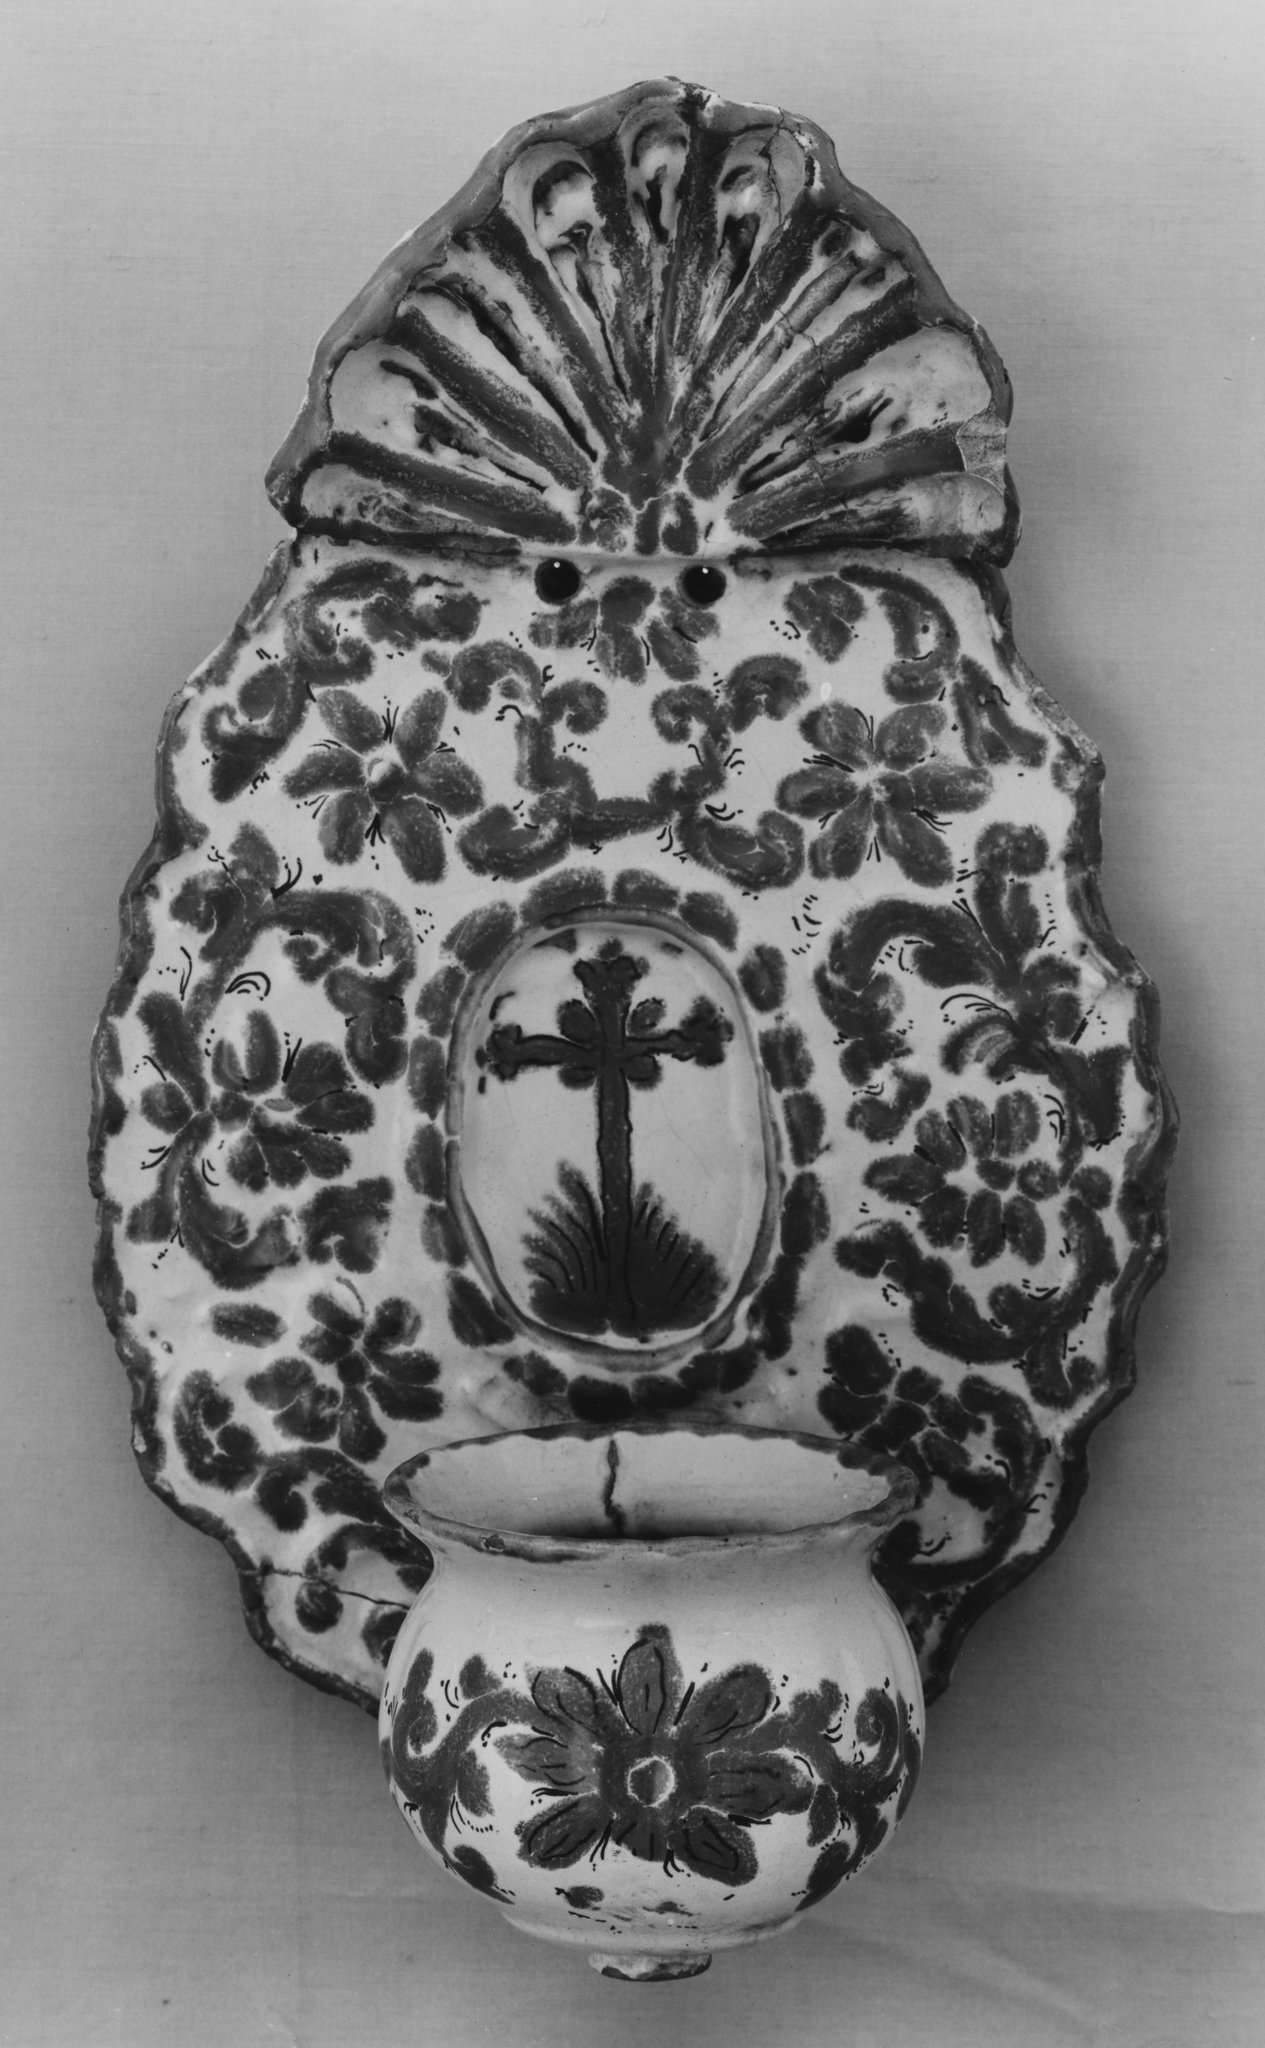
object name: holy water basin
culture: mexican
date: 1800-1900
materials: earthenware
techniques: glazing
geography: mexico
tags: flowers,cross